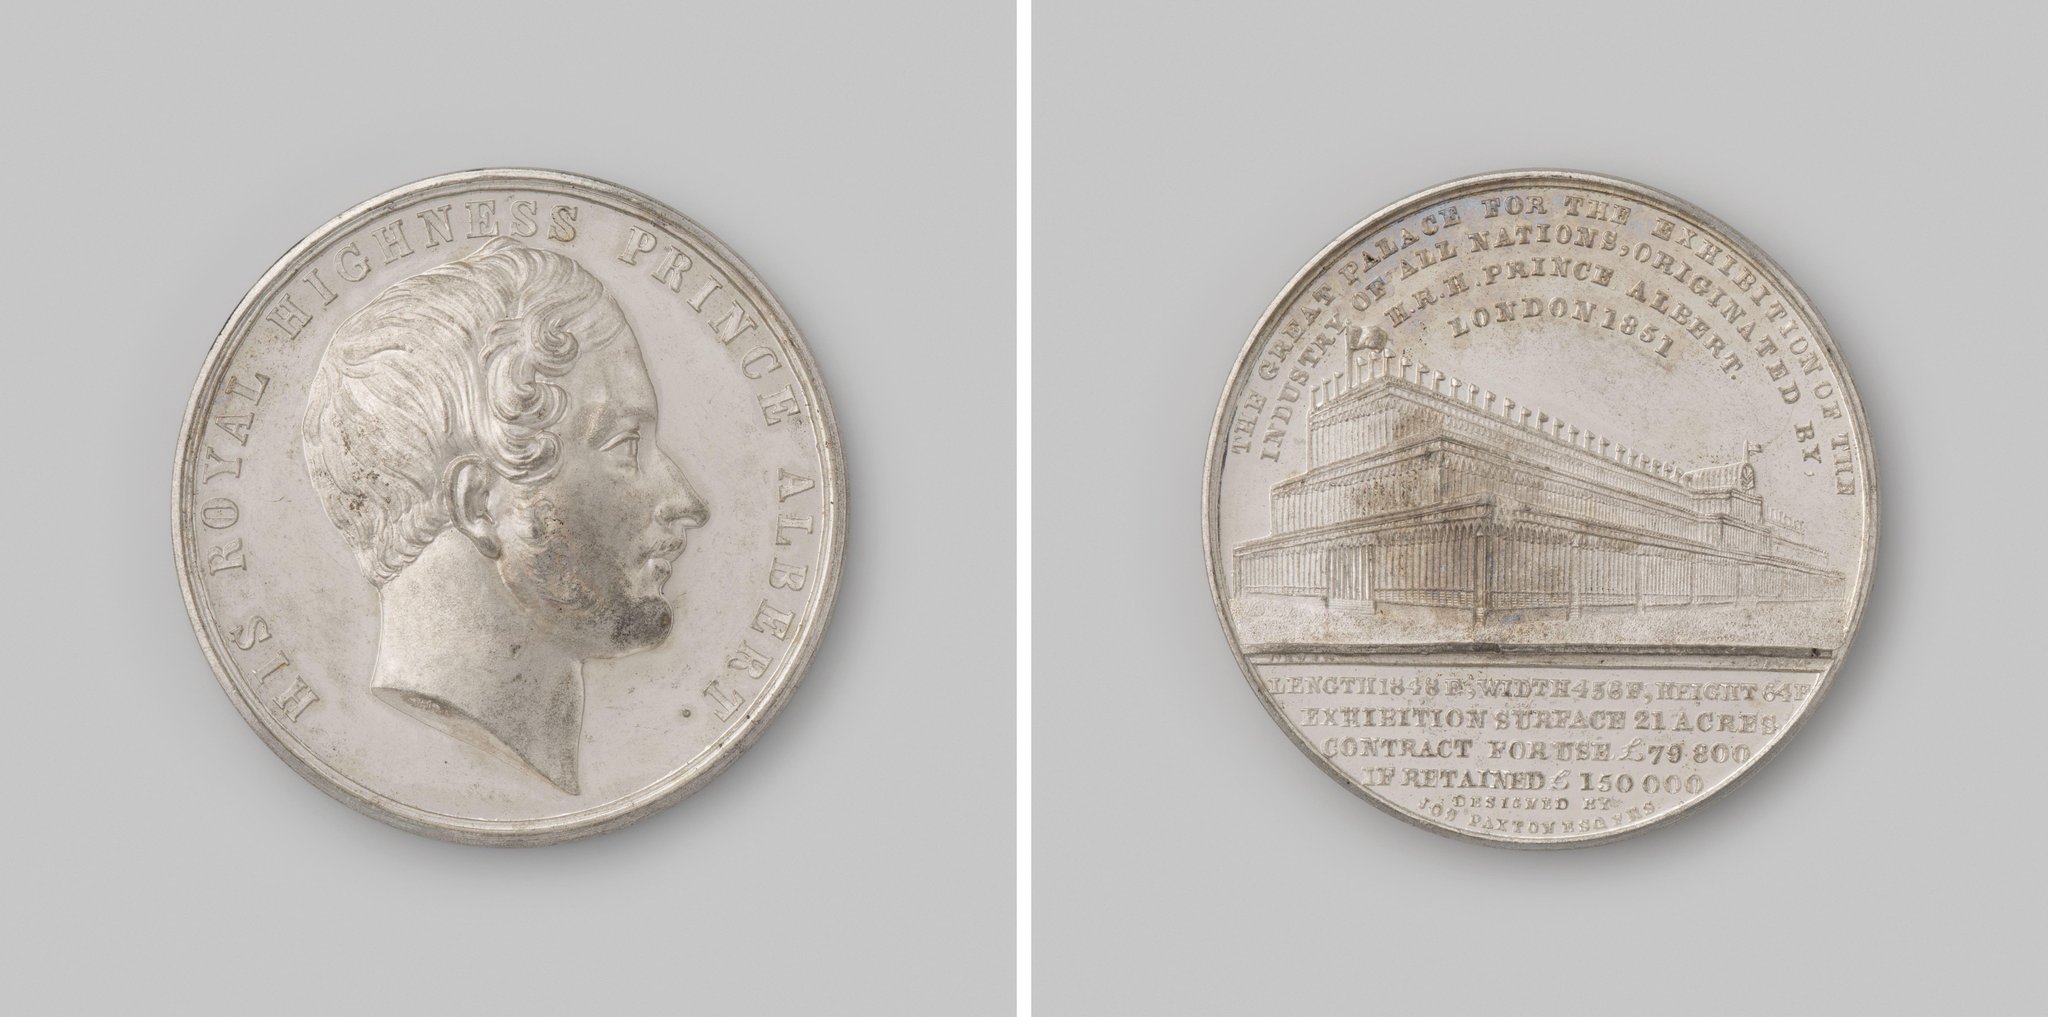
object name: history medal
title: Opening van het gebouw voor de Internationale Tentoonstelling te Londen 1851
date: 1851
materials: tin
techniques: striking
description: Tinnen penning, op de voorzijde het portret van Prins Albert naar rechts met omschrift, op de keerzijde vier regels tekst, het tentoonstellingsgebouw en zes regels afsnedetekst.